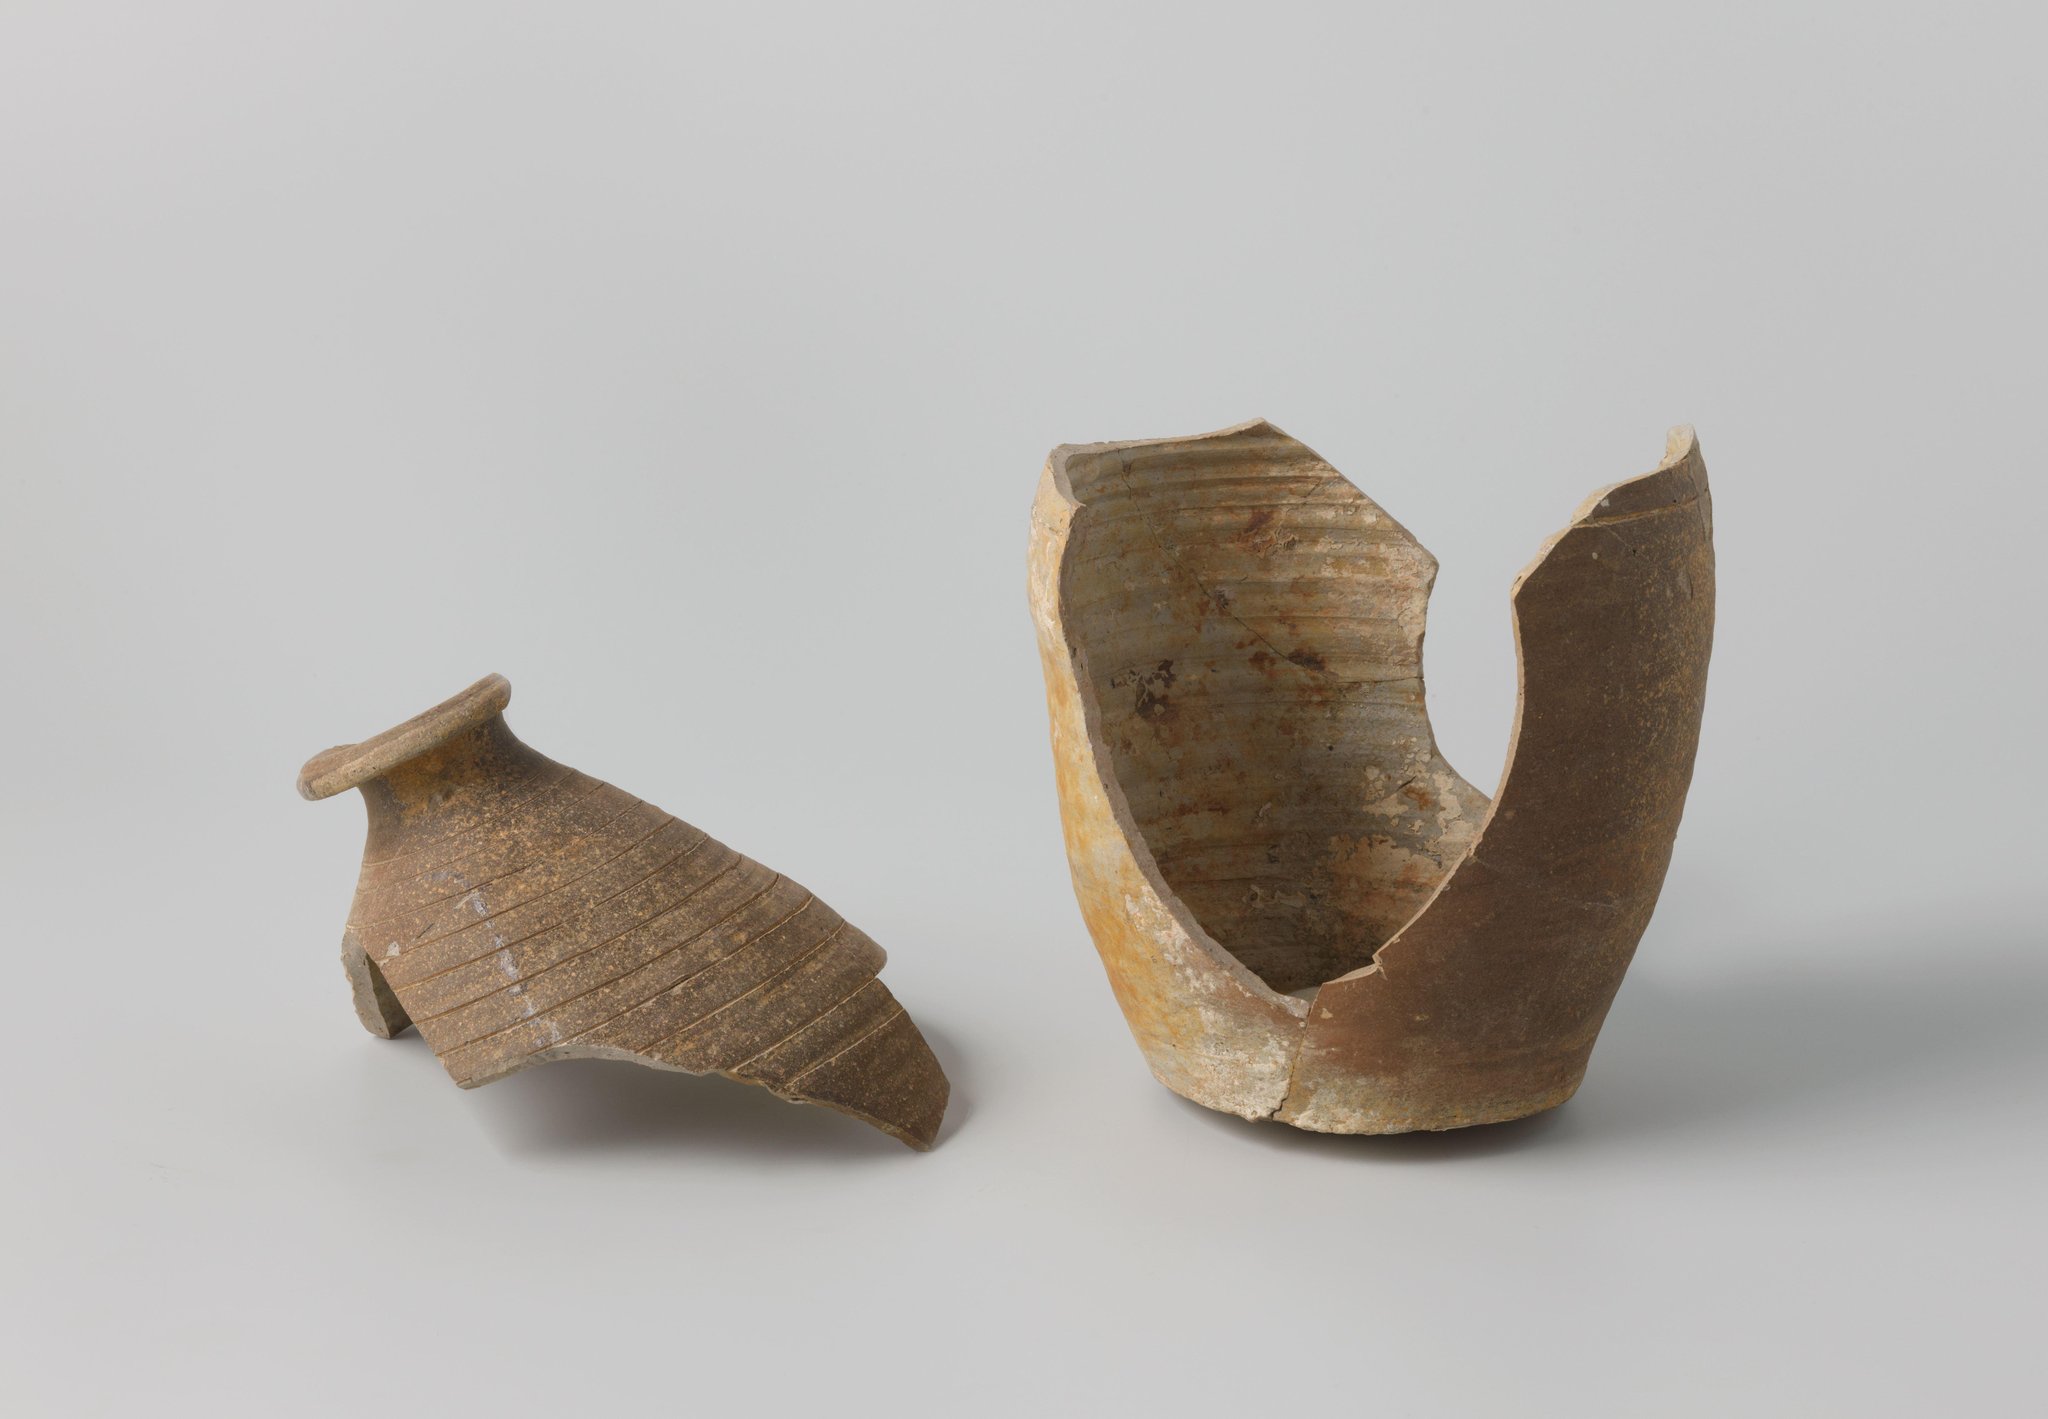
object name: sherd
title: Scherven van een martavaan uit V.O.C.-schip de 'Witte Leeuw'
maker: Anonymous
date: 1613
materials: porcelain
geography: southeast asia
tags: verenigde oostindische compagnie, sint-helena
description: A jar. This exceptional jar has a wide waist and narrows towards the neck which ends in a narrow flaring mouth. The thin, double walled base has bursted open. The grey coloured clay contains few impurities. There are no traces of glaze on the outside or inside. It has possibly been covered with a glaze or a slip. The upper half of the exterior has concentric grooves neatly incised from the neck to the waist.